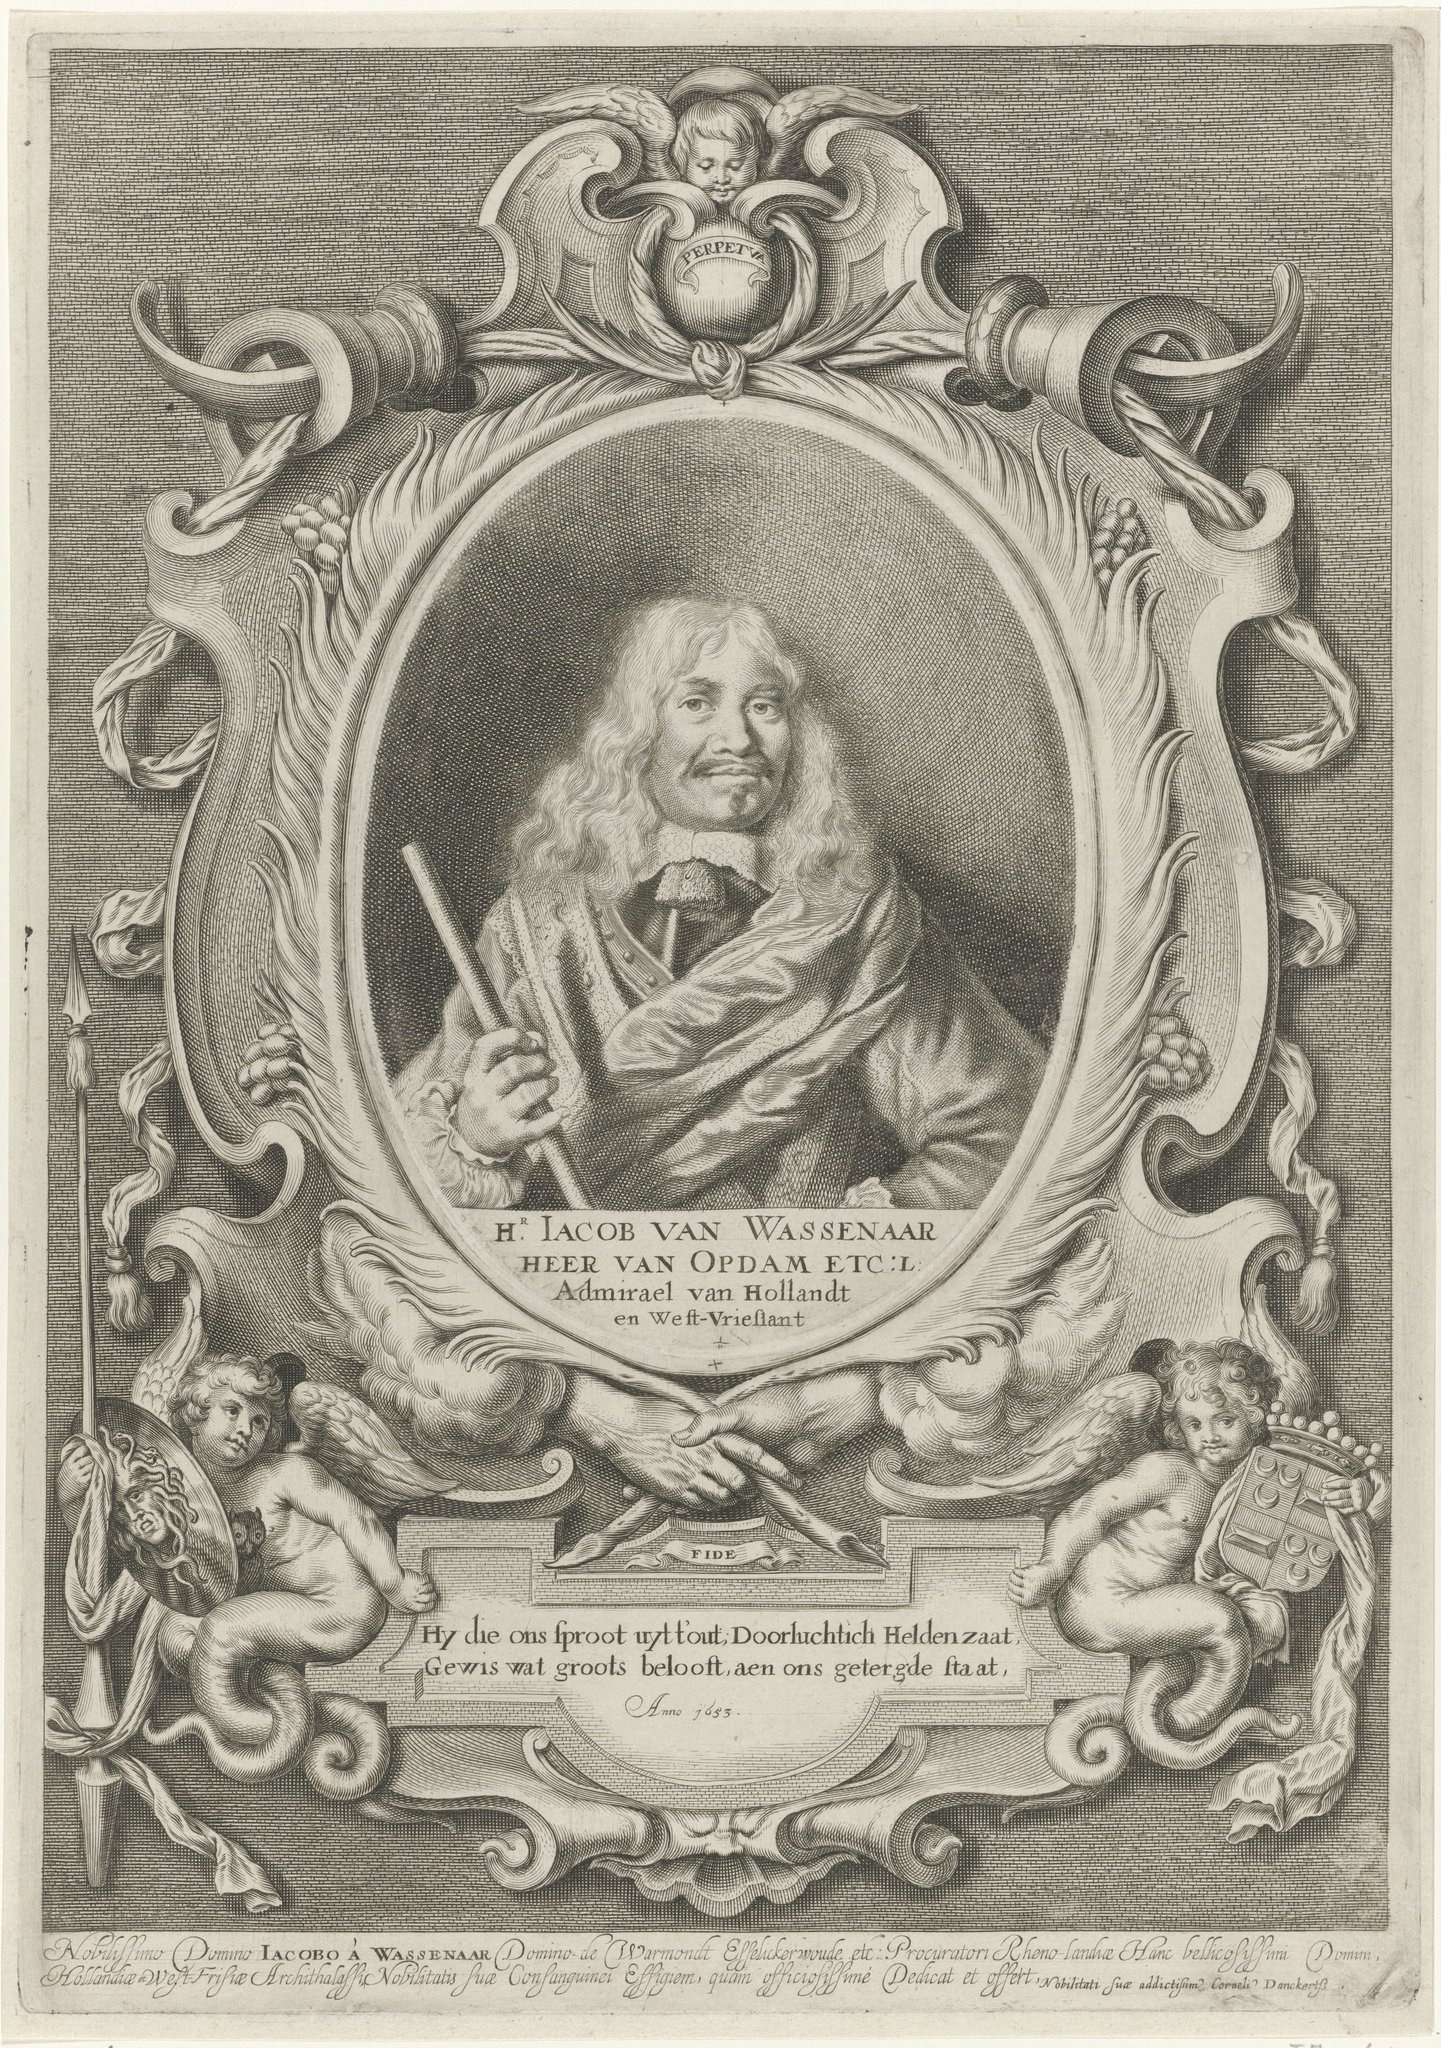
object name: print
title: Portret van Jacob baron van Wassenaer, heer van Obdam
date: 1653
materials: paper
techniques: engraving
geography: amsterdam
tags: jacob baron van wassenaer heer van obdam, shaking hands, 'dextrarum junctio', attributes of minerva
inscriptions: collector's mark: Lugt 2228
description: Portret van admiraal Jacob van Wassenaar, heer van Obdam, met een bevelhebbersstaf in zijn hand, gevat in een ornamentele lijst. Linksonder een putto met de attributen van Minerva, het schild met het hoofd van Medusa, de speer en een uil. Rechtsonder een putto met het wapenschild van Van Wassenaar.